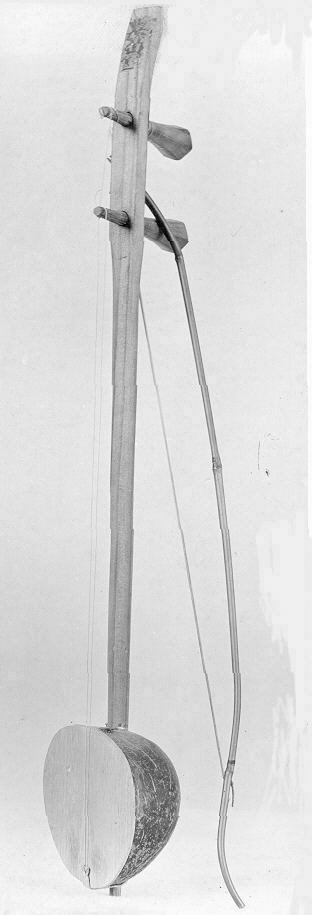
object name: yeh hu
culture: chinese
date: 1801-1900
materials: bamboo, hair, silk, wood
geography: china